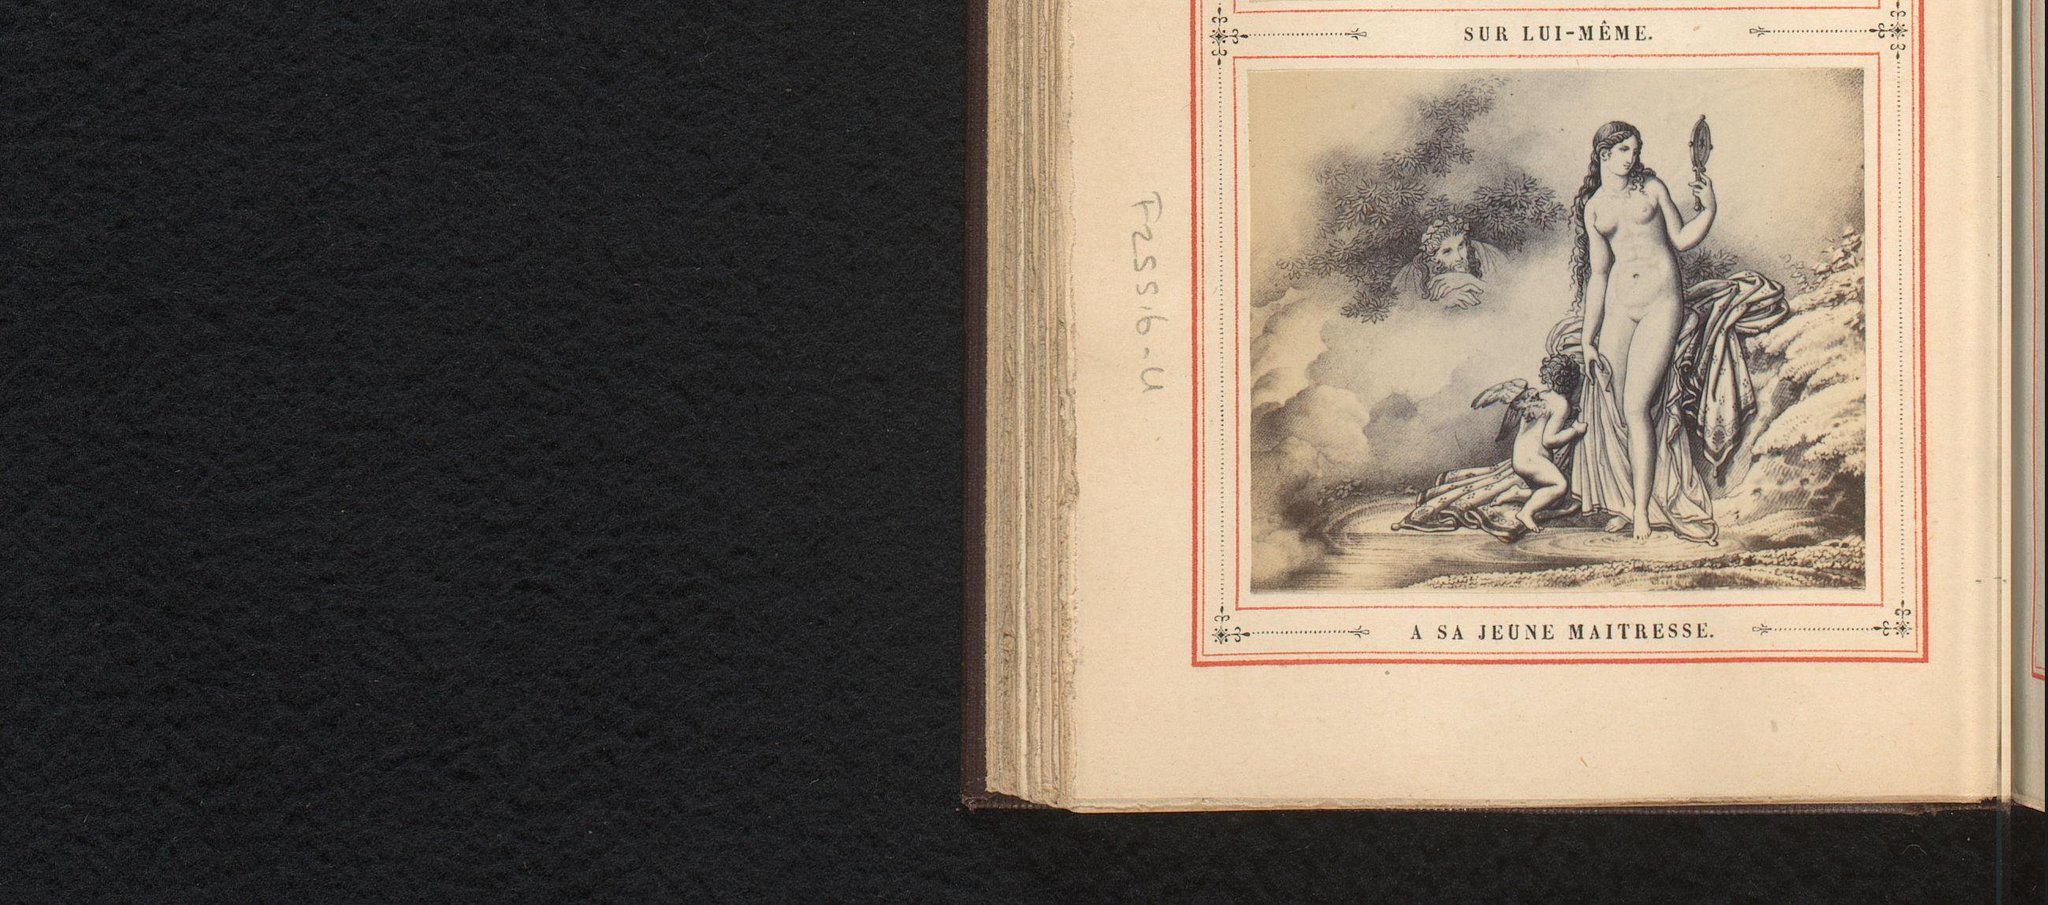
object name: photograph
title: Fotoreproductie van een tekening van Girodet, god met maîtresse, illustratie bij Apothéose d'Anacréon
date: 1859-1864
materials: paper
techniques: albumen print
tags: gods ~ classical mythology